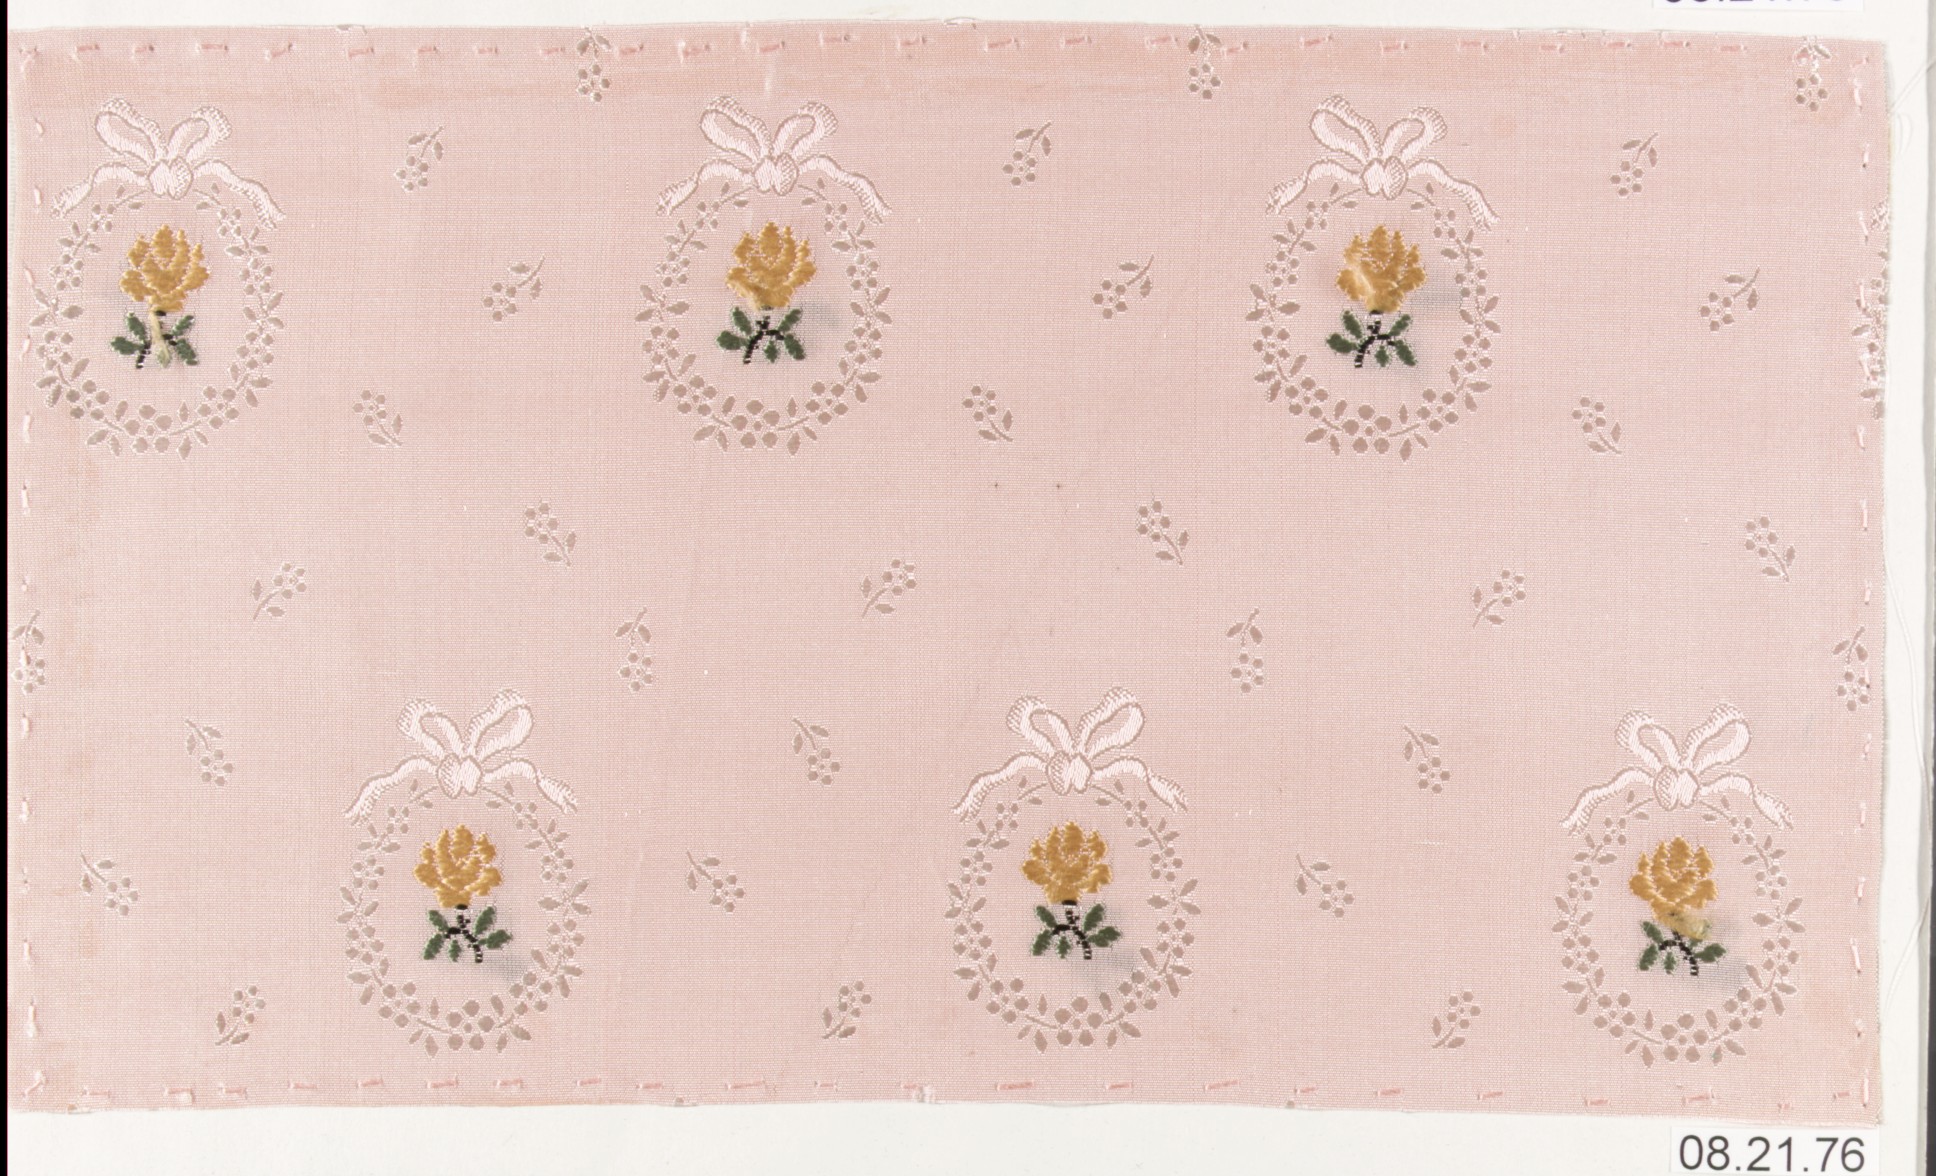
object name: textile sample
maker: Anonymous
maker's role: designer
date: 1900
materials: silk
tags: flowers